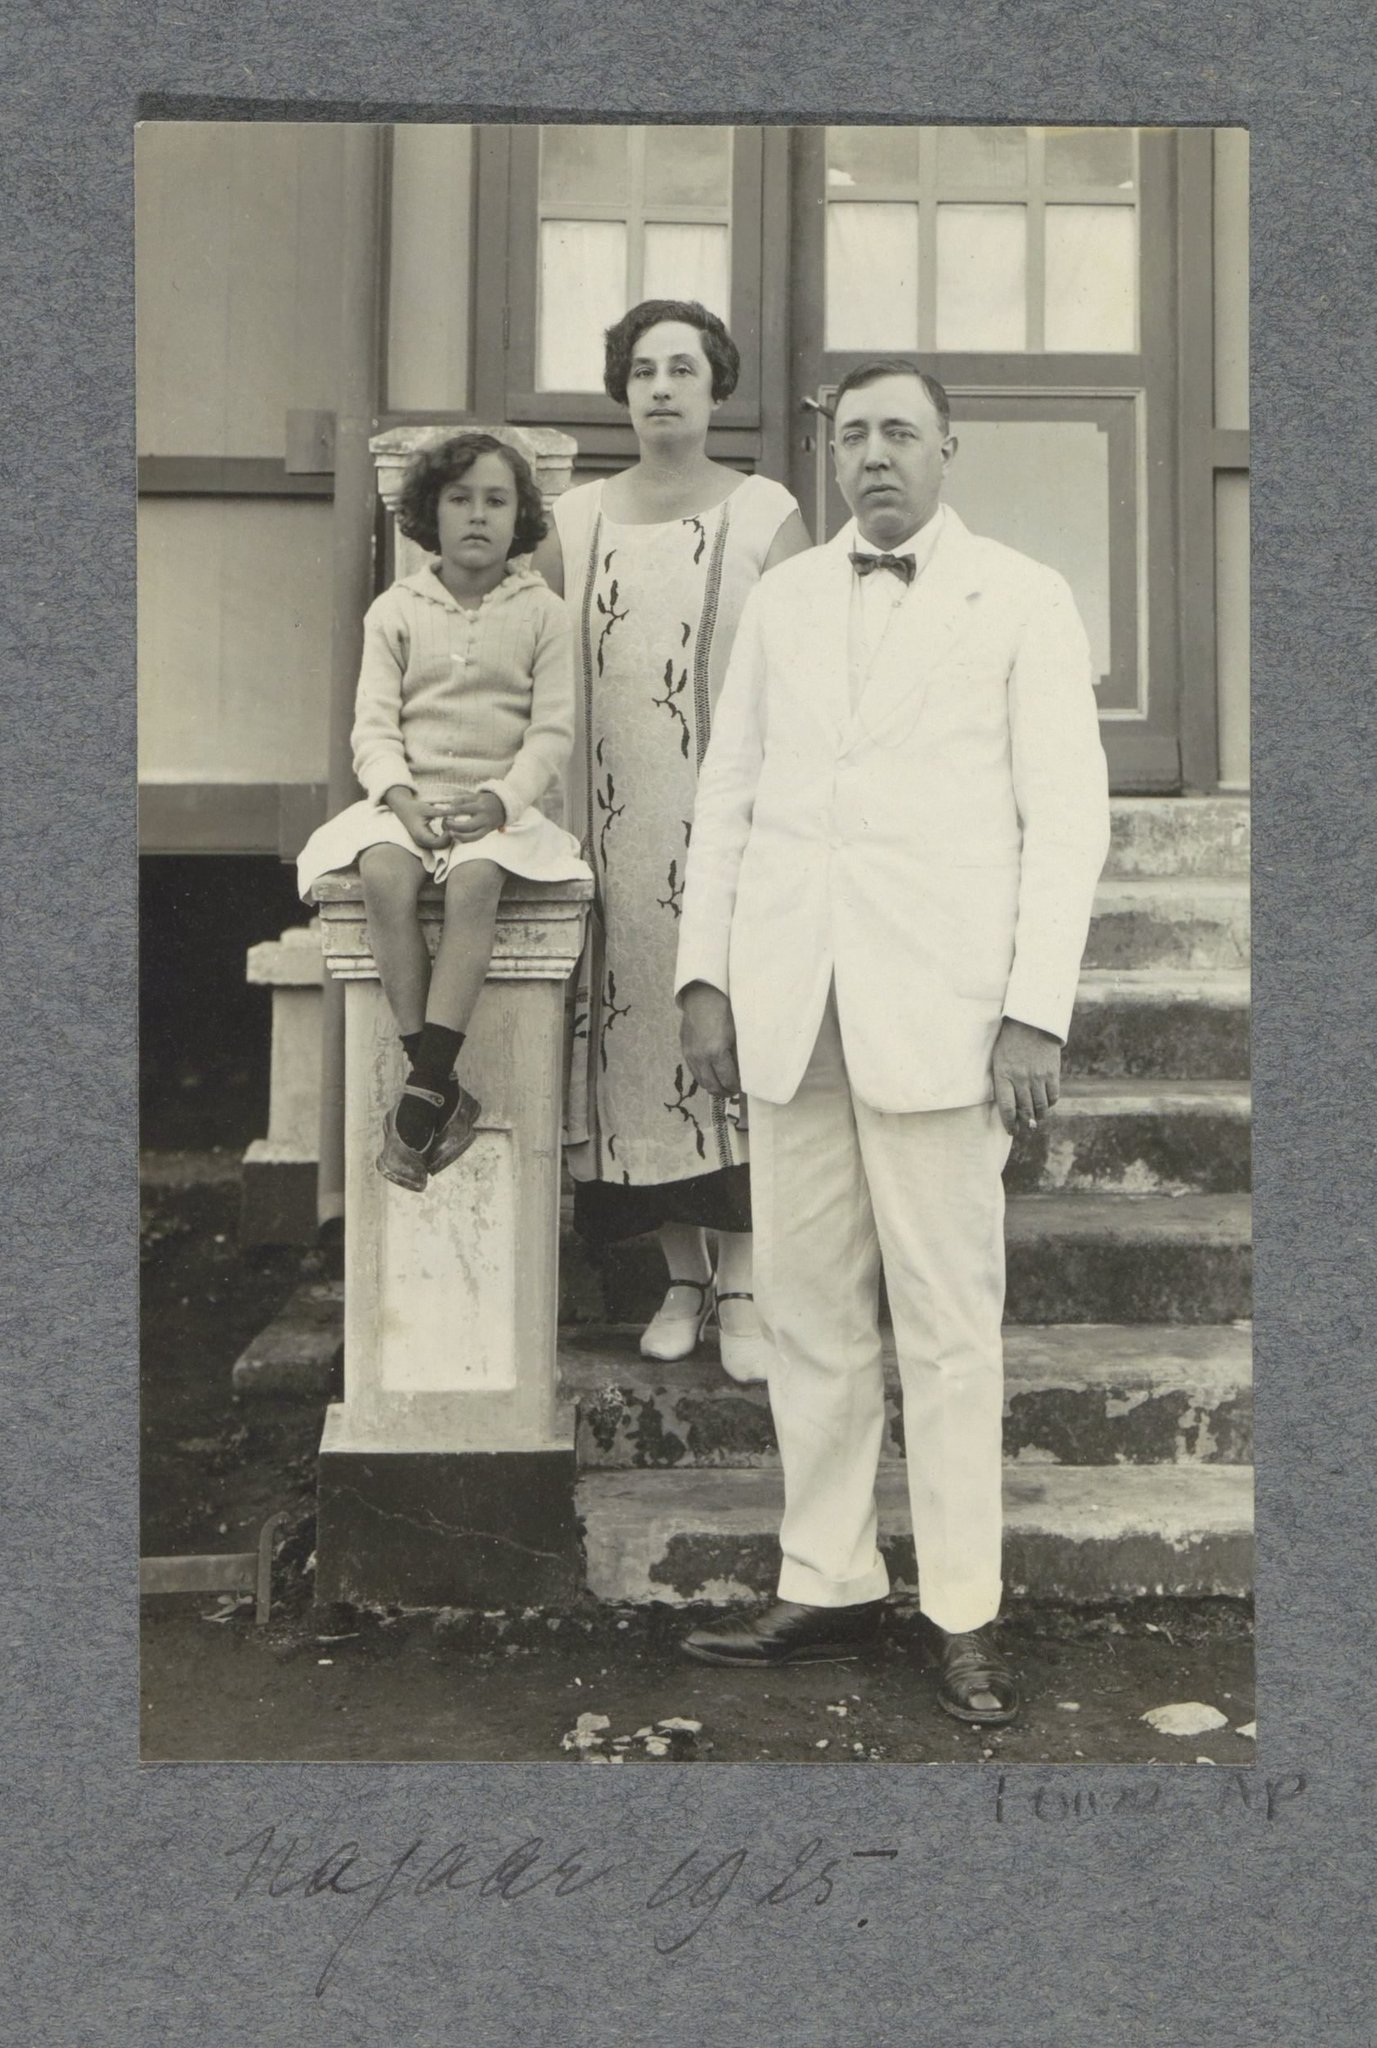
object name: photograph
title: Eiso en Gerda Bergsma met hun dochter Netta op een bordes op Sumatra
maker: Anonymous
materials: photographic support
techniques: gelatin silver print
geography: sumatra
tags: family group, especially parents with their child(ren), sumatra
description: Onderdeel van fotoalbum met opnames van de familie Bergsma in Tandjong Poera en Rantan Pandjang (Sumatra).